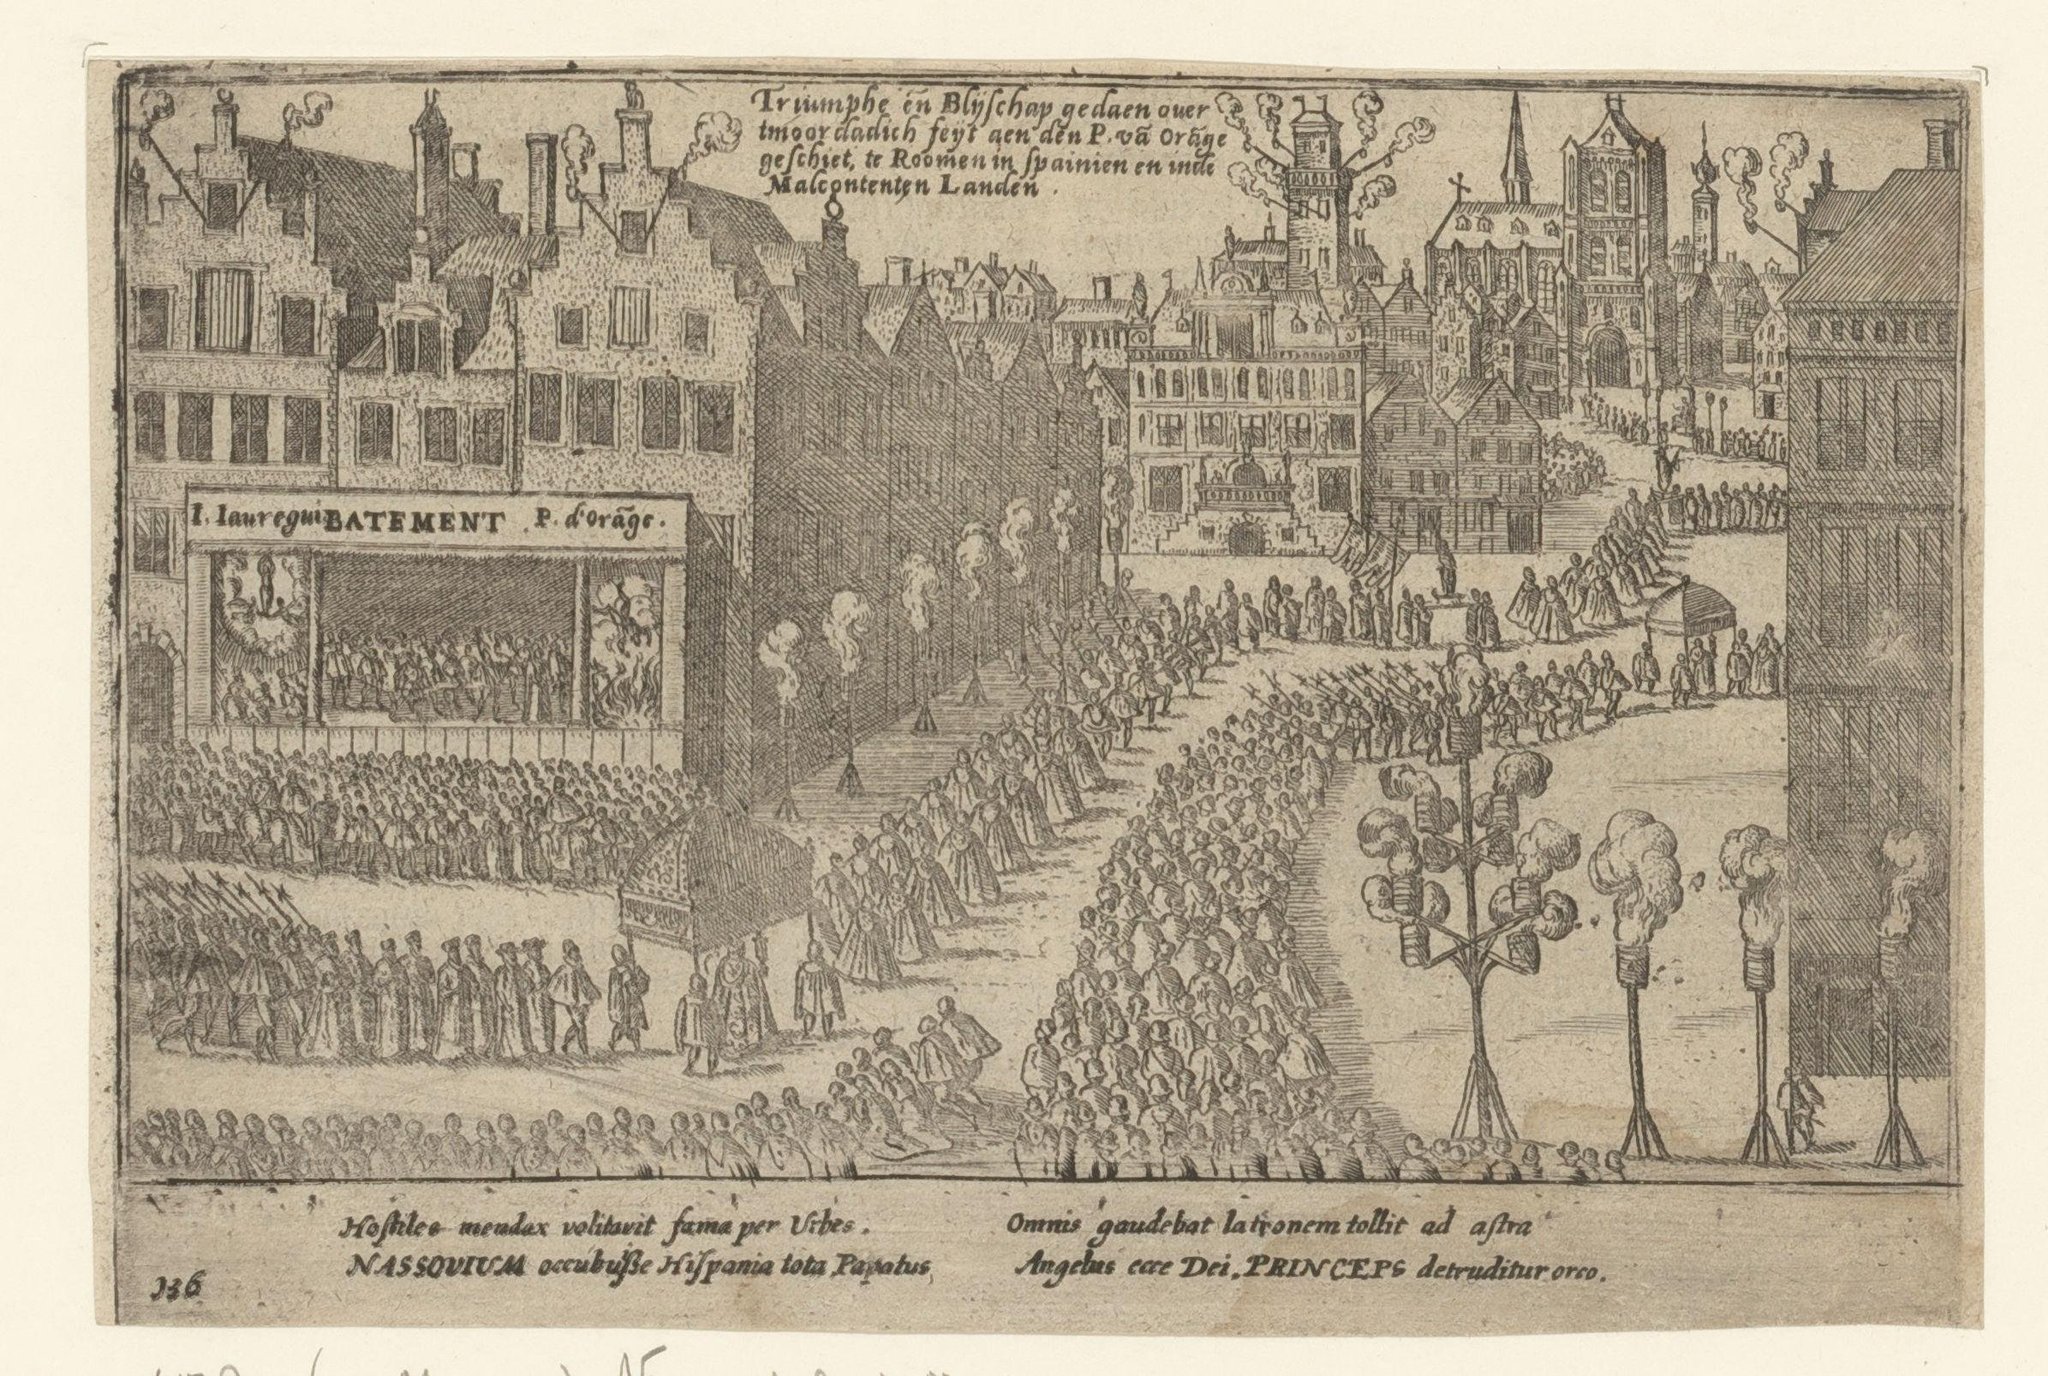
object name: history print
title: Triumphe en[de] Blijschap gedaen over tmoordadich feyt aen den P. va[n] Ora[n]ge geschiet, te Roomen in Spainien en inde Malcontenten Landen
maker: Anonymous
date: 1613-1615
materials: paper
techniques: etching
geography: northern netherlands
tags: group of actors, troupe; actors on the stage, festivities (+ illumination, fire-works ~ festive activities), procession ~ christian religion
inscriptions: collector's mark, collector's mark: Lugt 1641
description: Blijdschap in andere landen na het nieuws van de aanslag van Jean de Jauregui op Willem van Oranje op 18 maart 1582. Straatbeeld met processie, vreugdevuren en toneelvoorstelling. Met onderschrift van 4 regels in het Latijn. Genummerd 136. Bedrukt op achterzijde met tekst in het Nederlands. Onderwerpsrubrieken binnen de Atlas Zeden en Gewoonten: Krijgswezen; prenten van Baudart. 80j. oorlog.